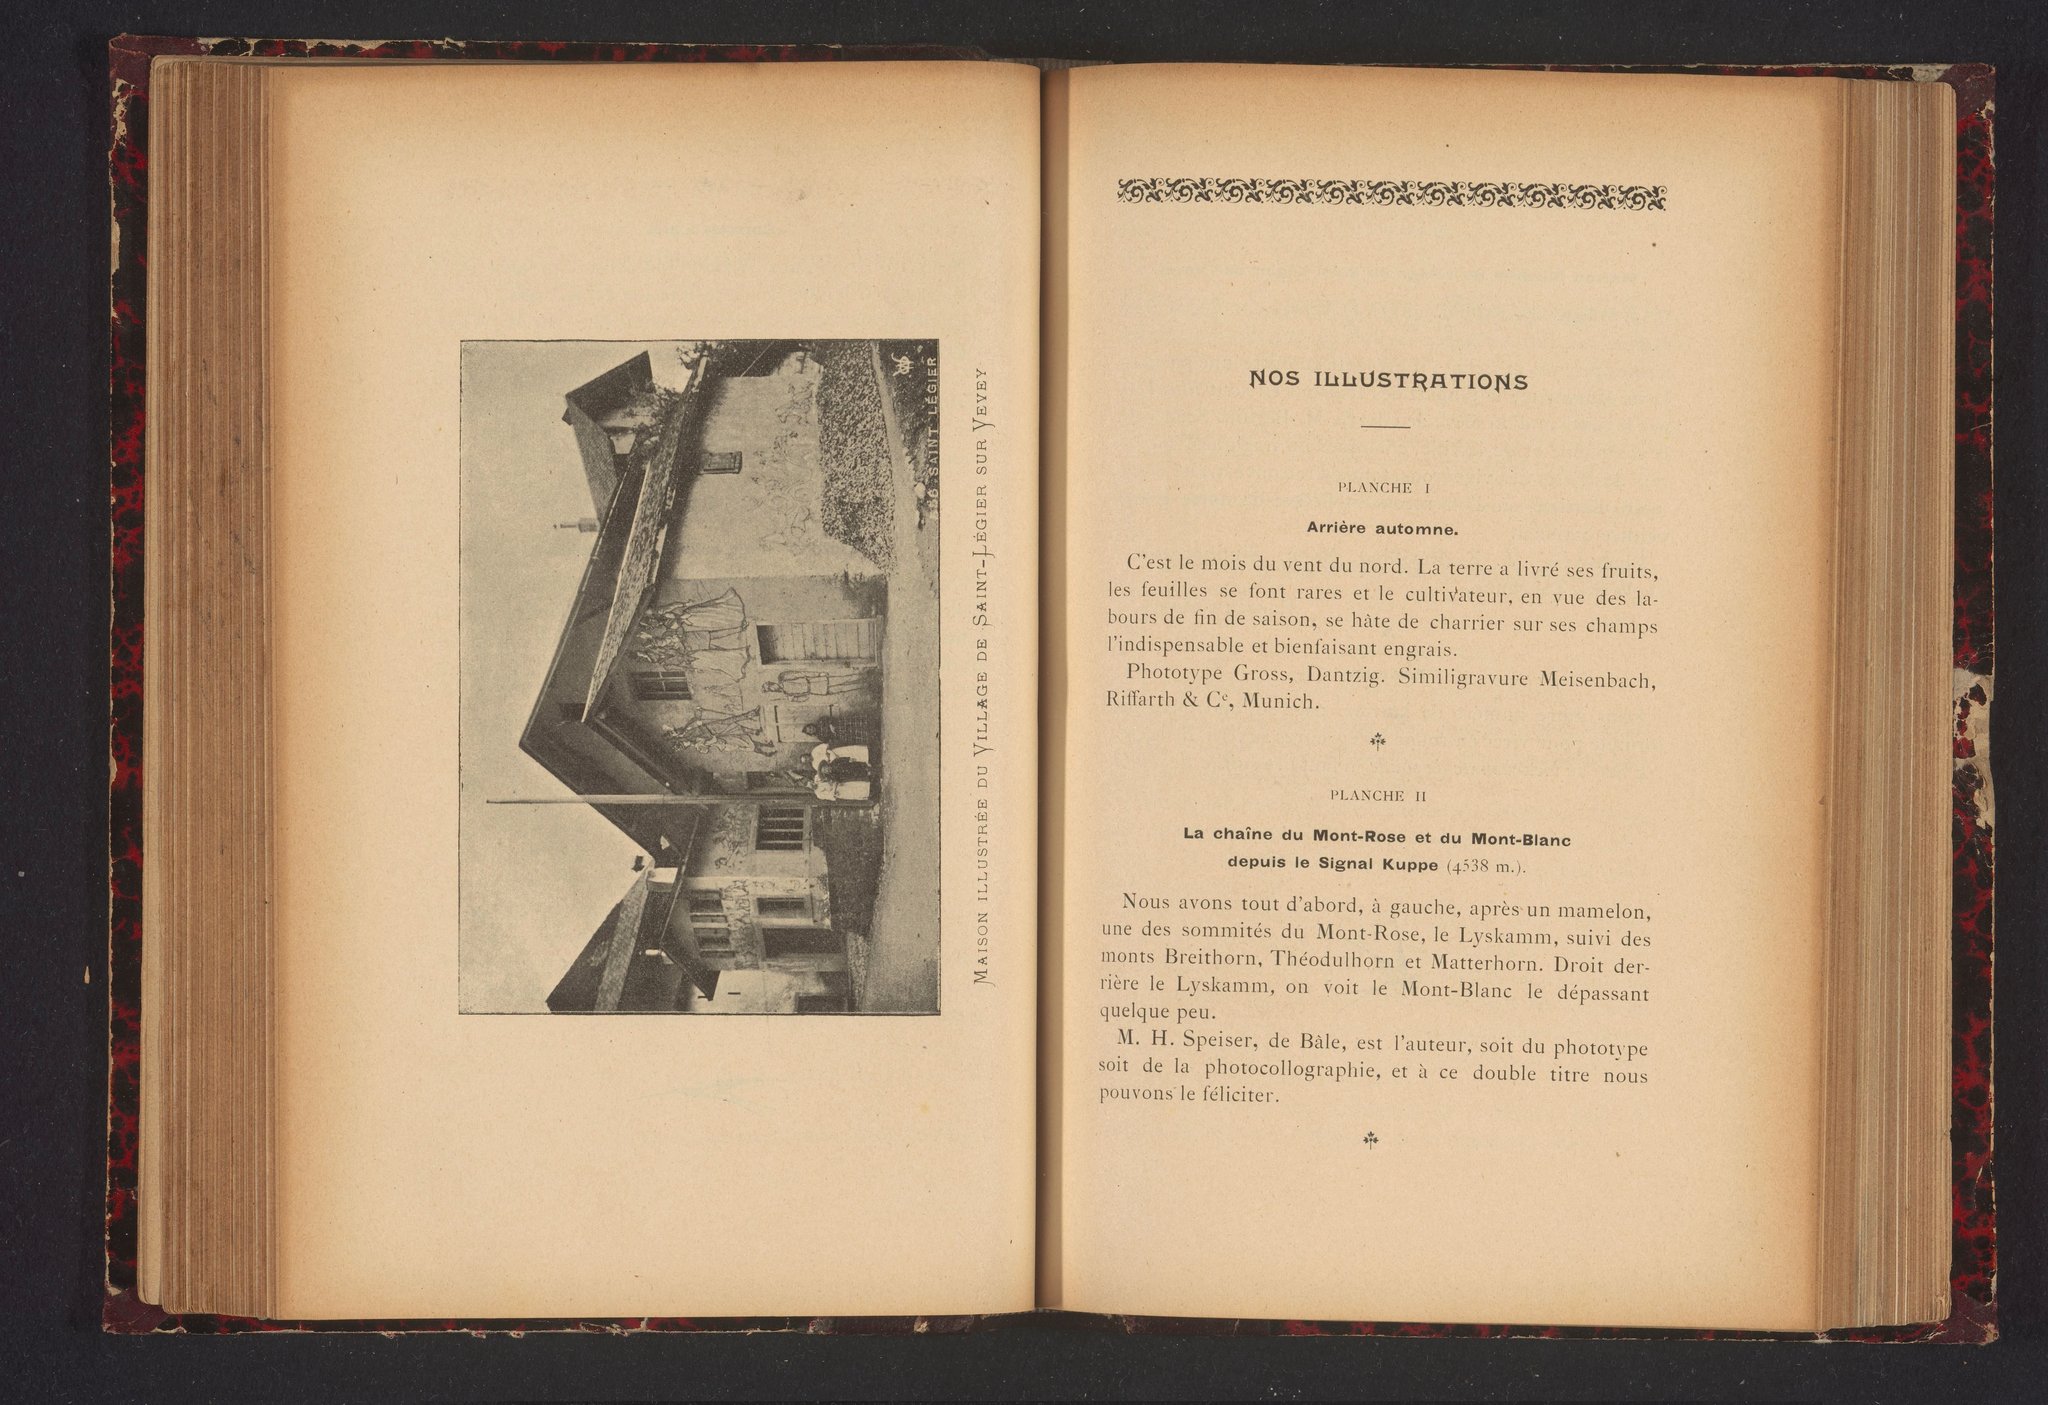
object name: photomechanical print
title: Gezicht op een huis met gedecoreerde gevel in Saint-Légier-La Chiésaz, Zwitserland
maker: Anonymous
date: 1894-1899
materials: paper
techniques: autotype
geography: saint-légier-la chiésaz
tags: civic architecture; edifices; dwellings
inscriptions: inscription: ‘556 SAINT LÉGIER’, monogram: ‘WO’